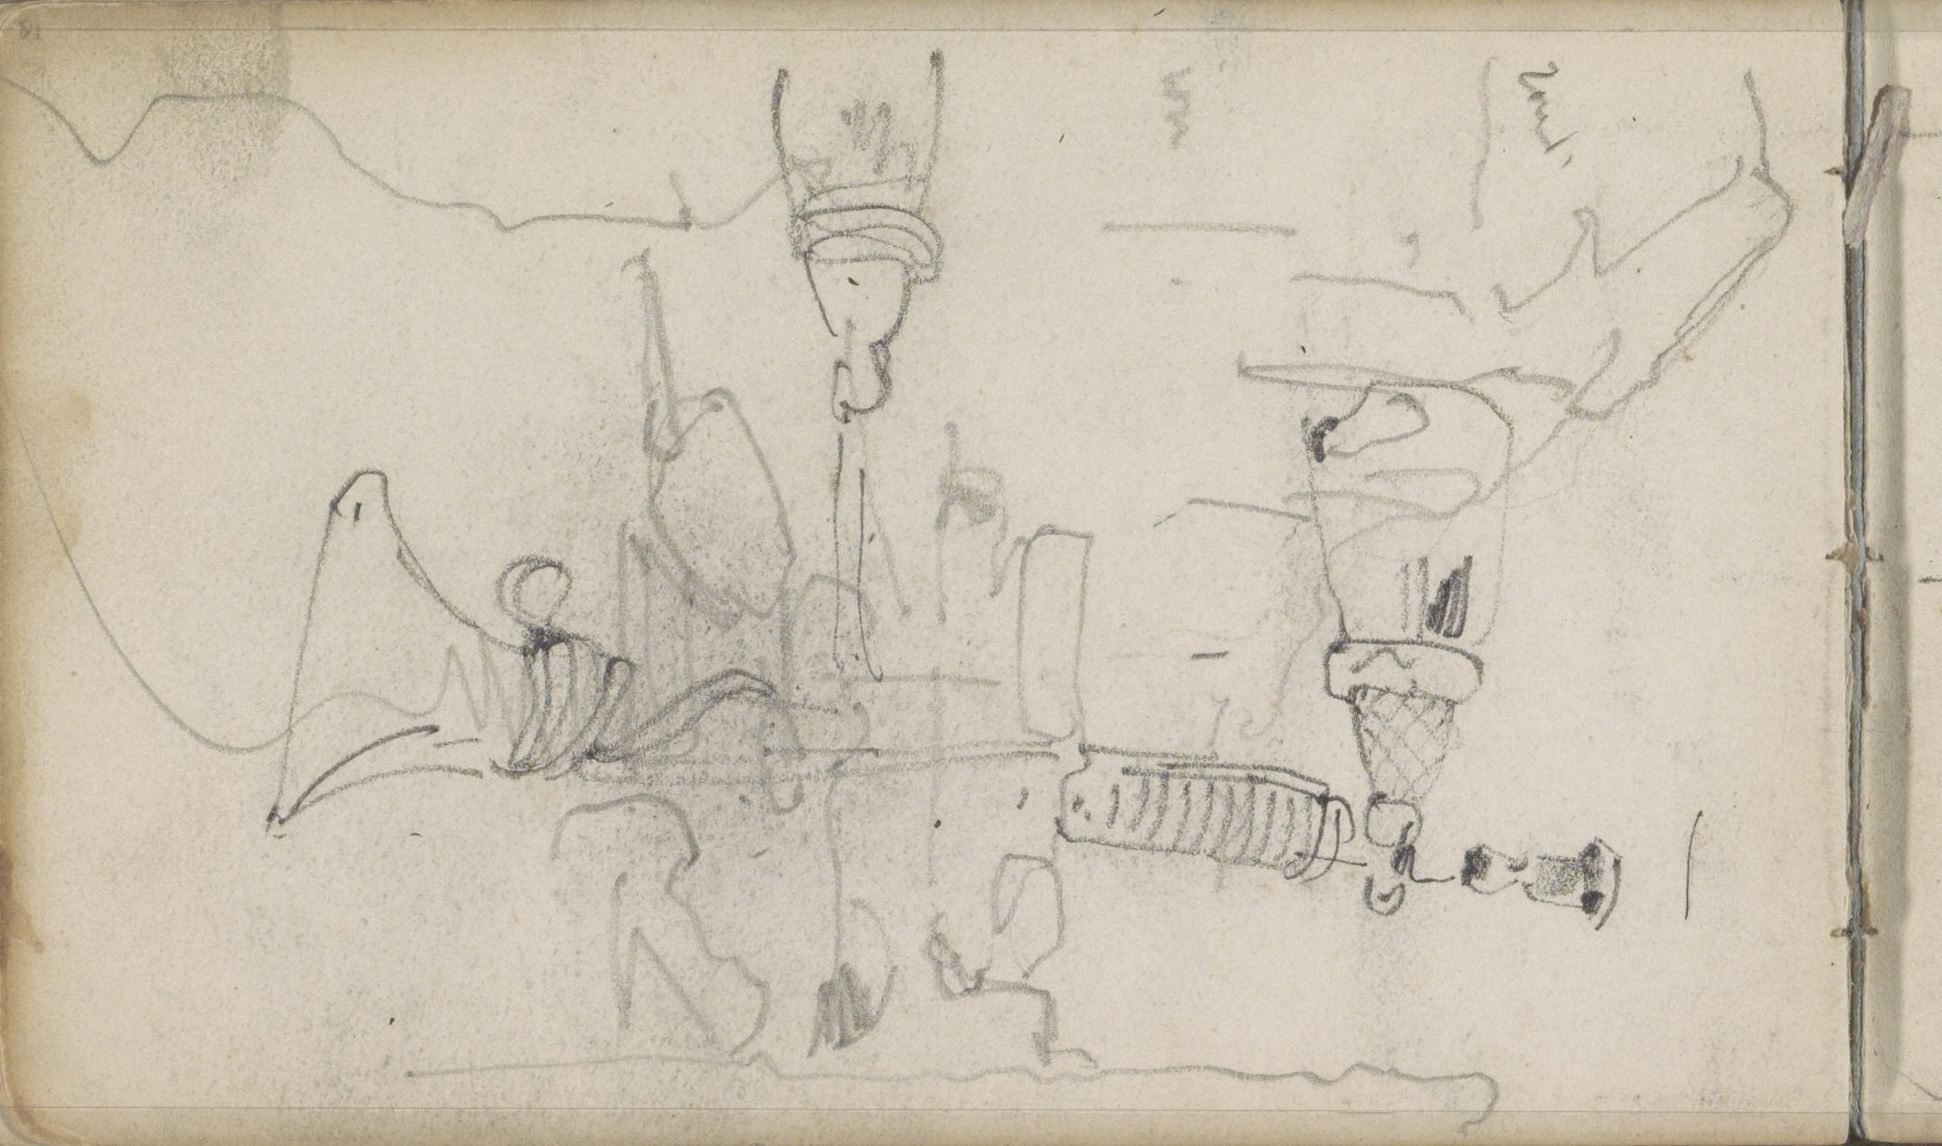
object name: sketchbook leaf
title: Landschap en een trompet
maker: george hendrik breitner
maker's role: draughtsman, painter, print maker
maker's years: 1857-1923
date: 1881-1883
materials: paper, pencil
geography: north brabant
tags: landscapes, horn, trumpet, cornet, trombone, tuba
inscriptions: annotation: ‘zand’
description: Pagina 81 uit een schetsboek met 42 bladen.